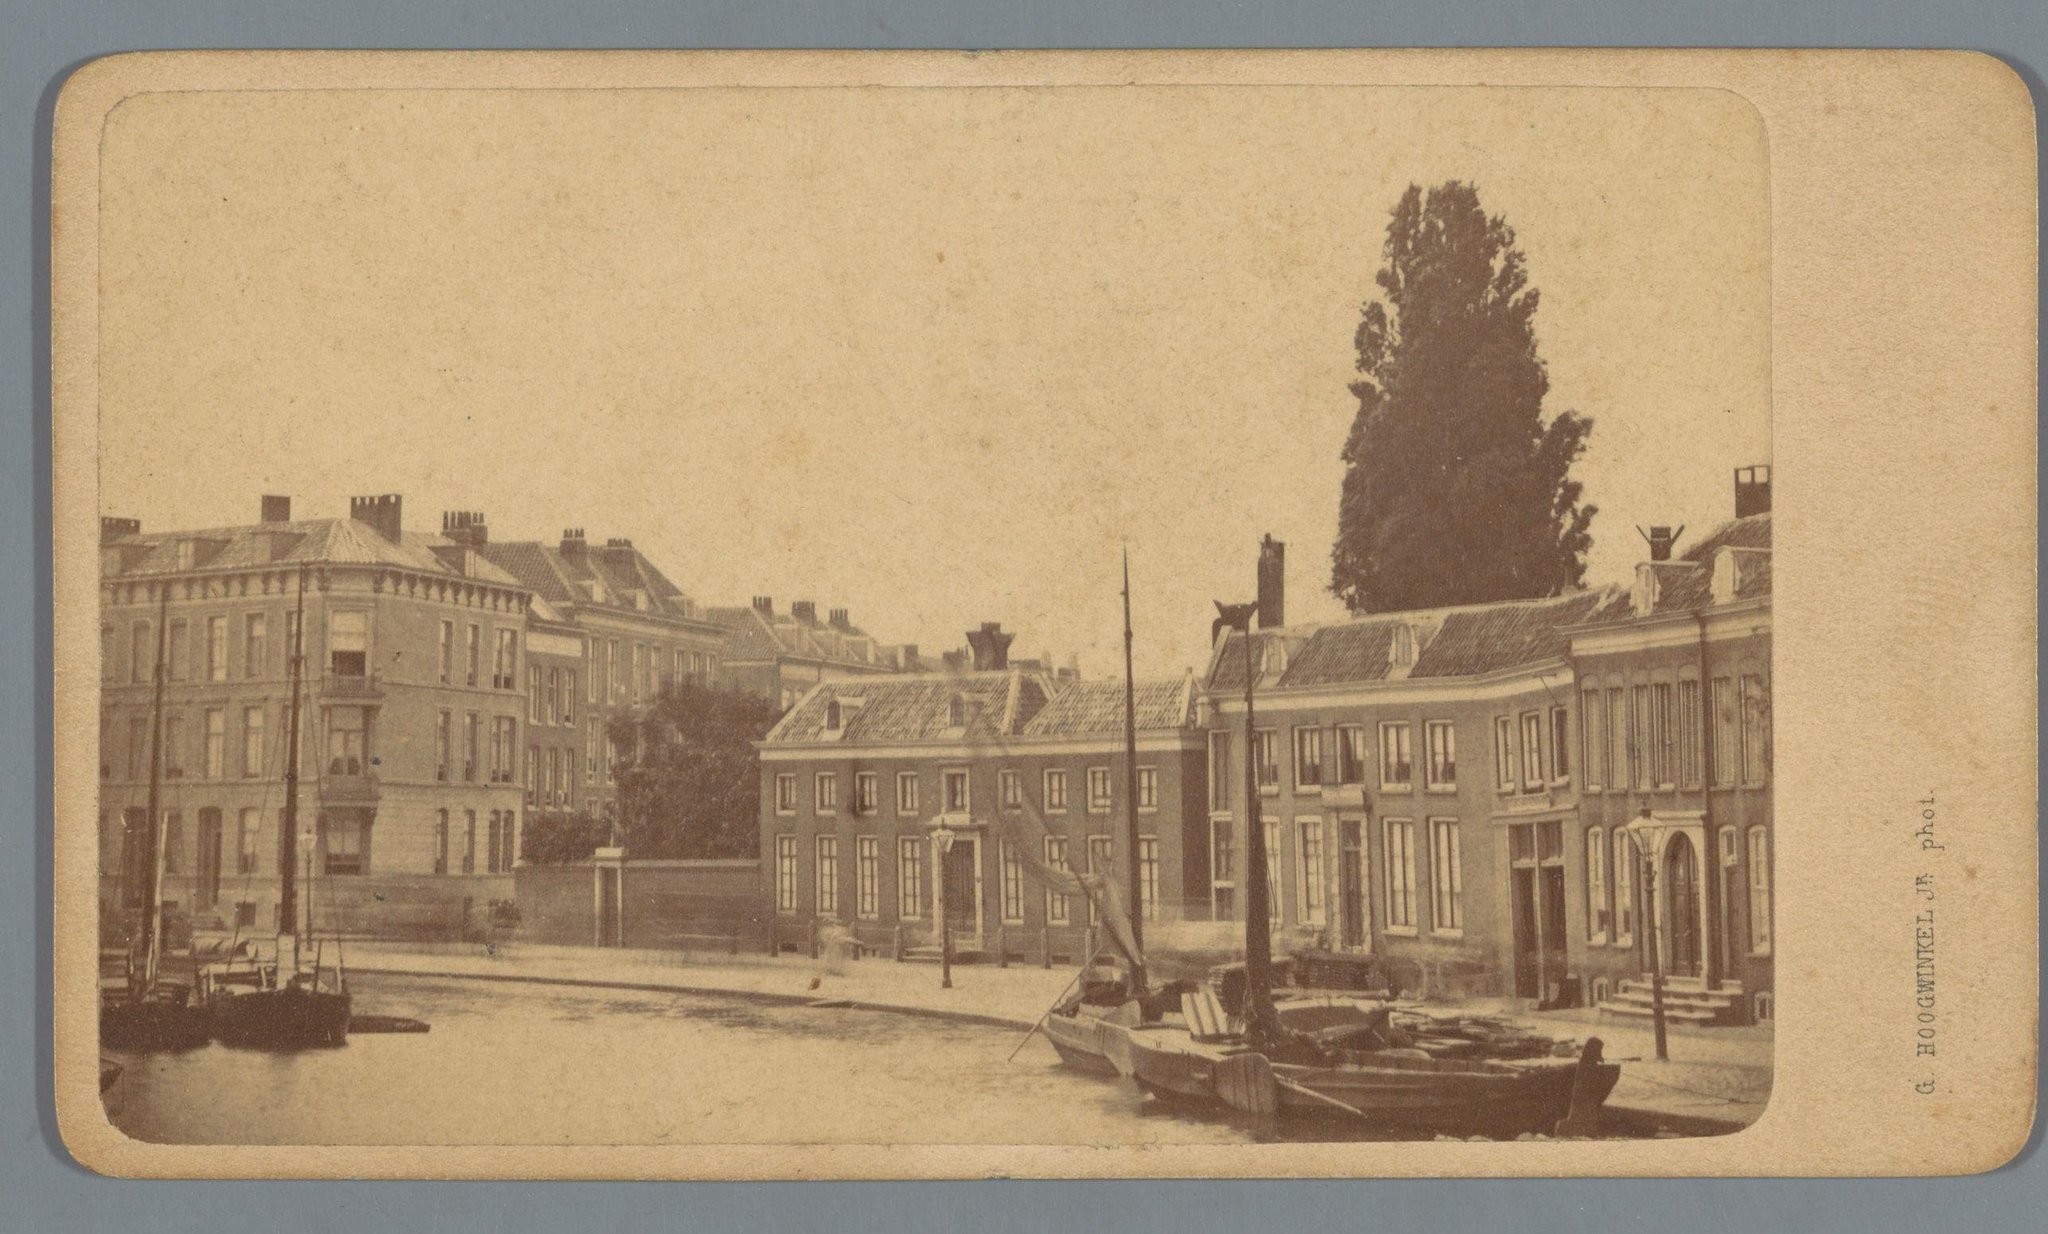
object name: carte de visite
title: Gezicht op de Schiedamsesingel te Rotterdam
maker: gerrit hoogwinkel jr.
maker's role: fotograaf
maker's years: 1837-1890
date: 1850-1900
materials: cardboard, photographic support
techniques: albumen print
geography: rotterdam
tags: canals, waters (in city), rotterdam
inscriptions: retailer's mark: ‘G. Hoogwinkel jr. / Photograhe/ Rotterdam/ 56, Hoogstraat.’